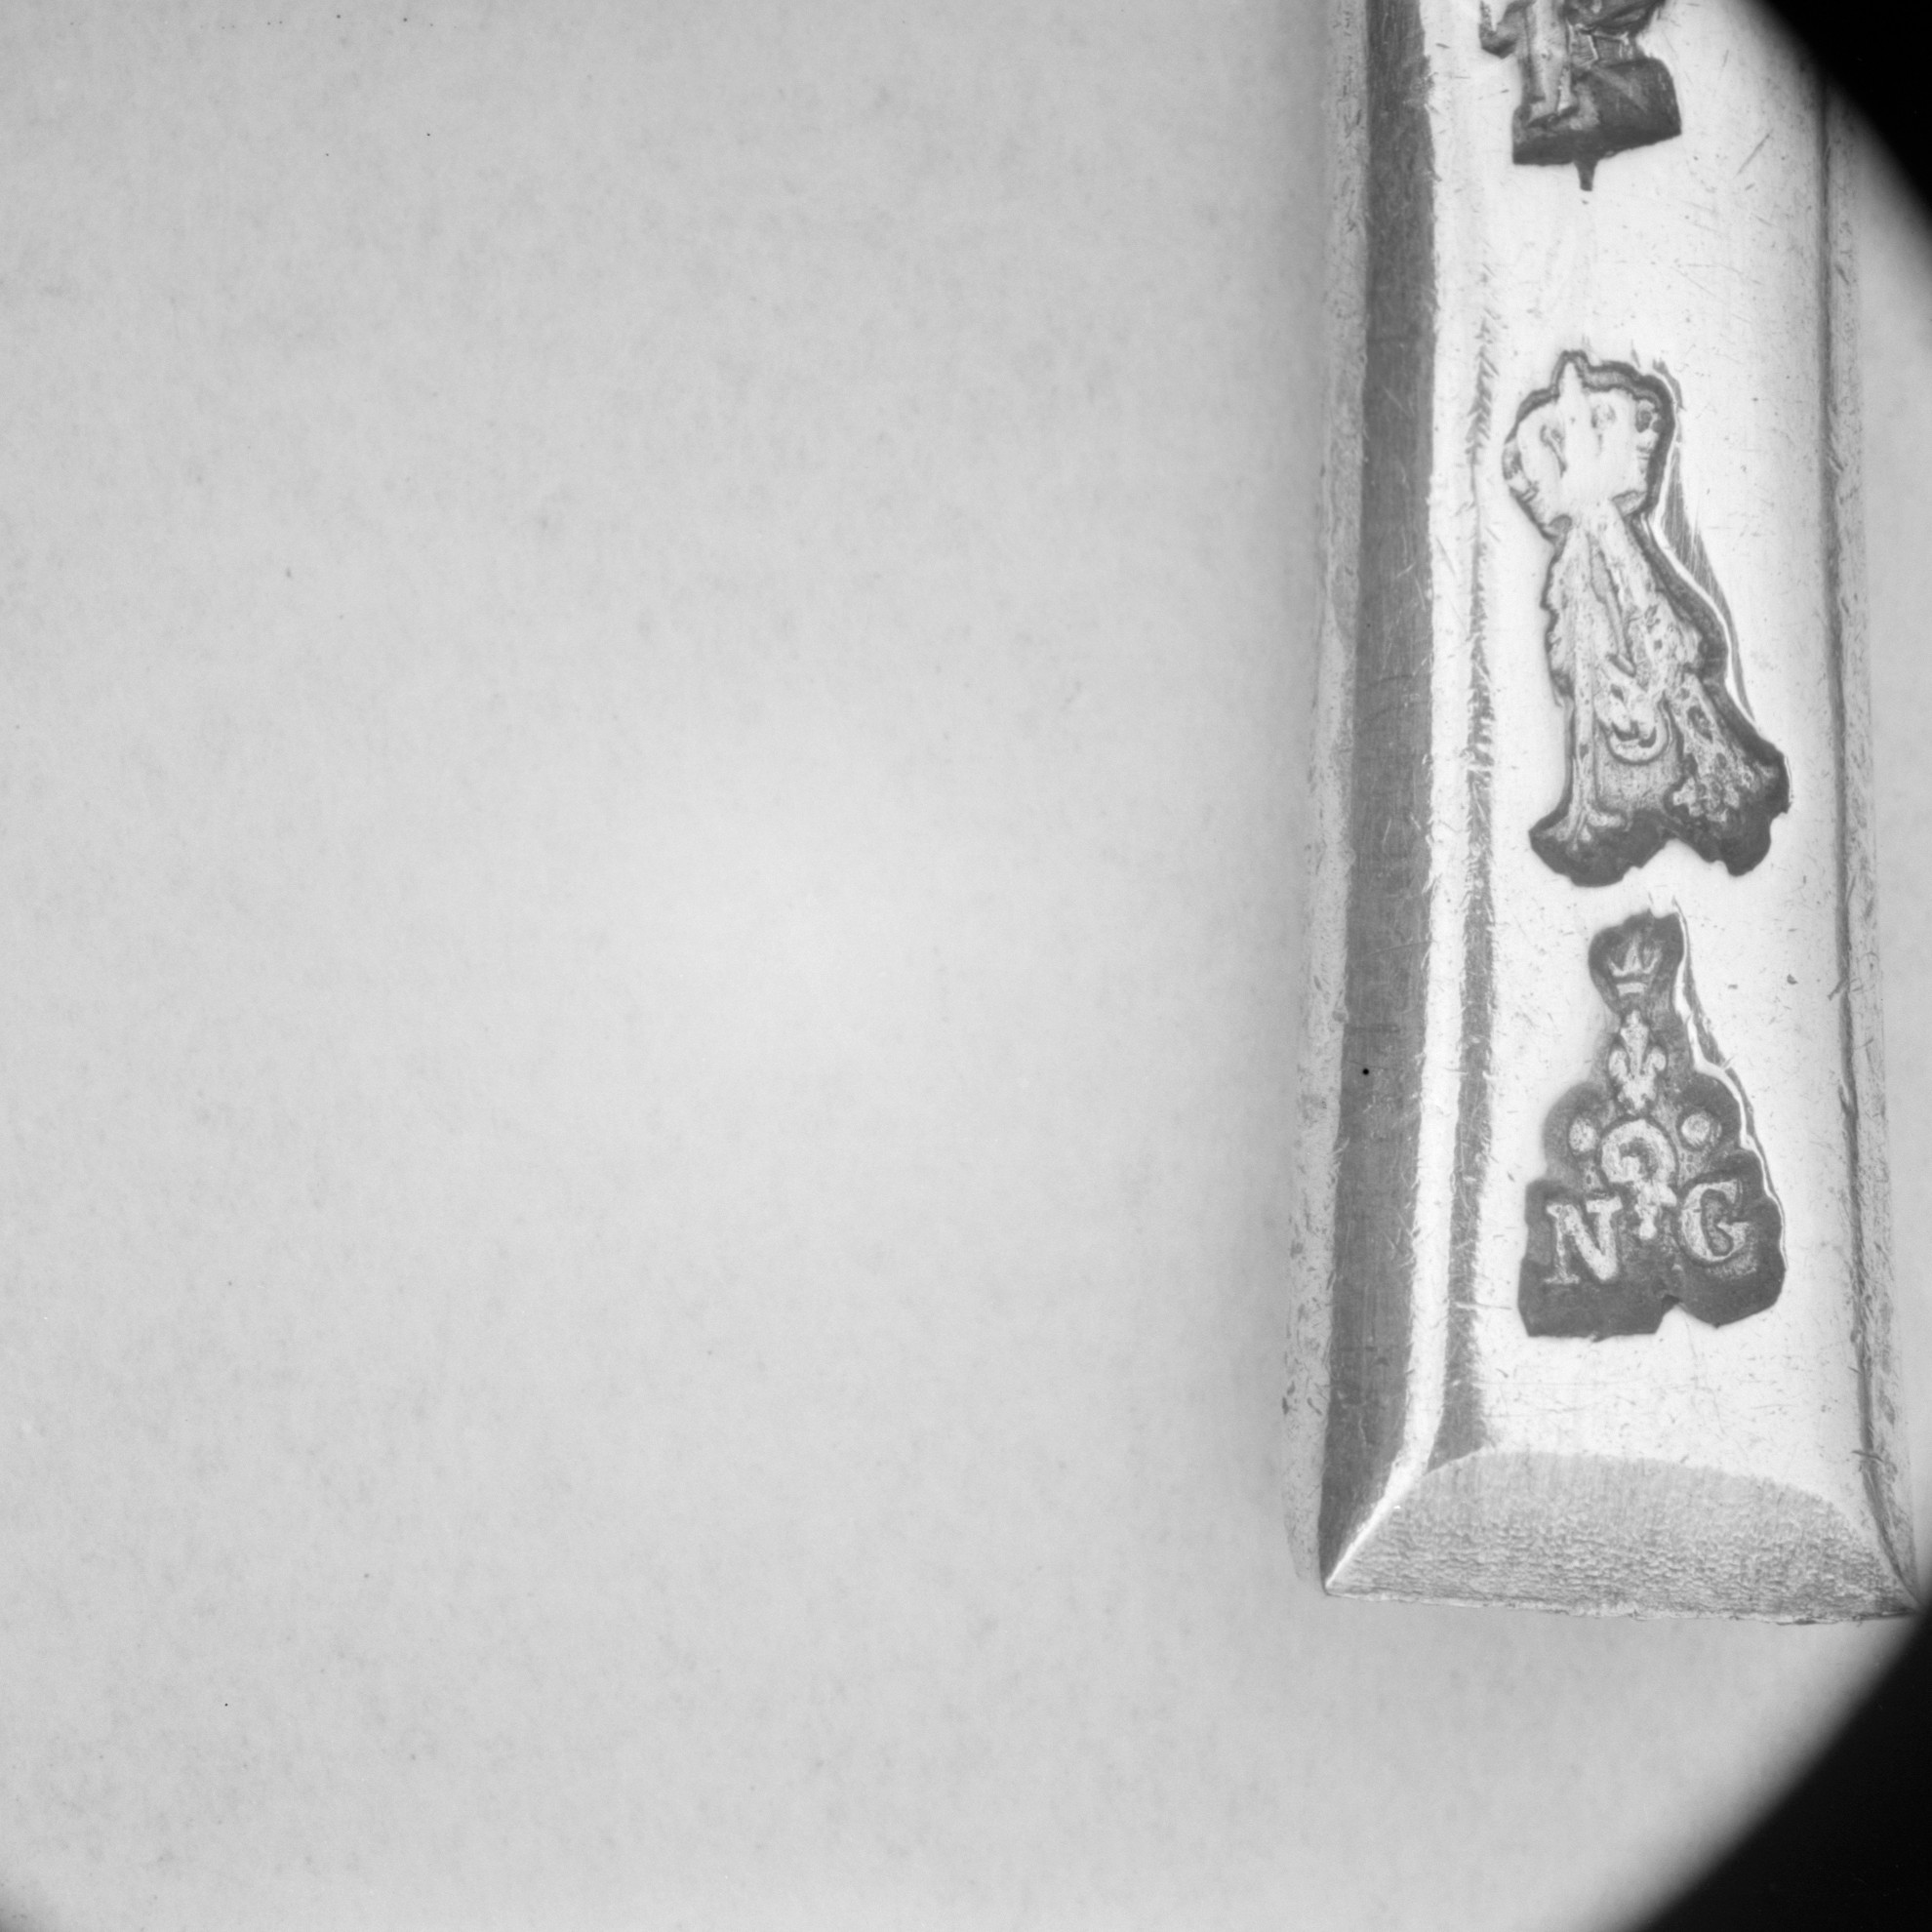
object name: spoon handle section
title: Section of a spoon handle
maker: nicolas gonthier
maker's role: maker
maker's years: 1738-1823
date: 1782-1783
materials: silver